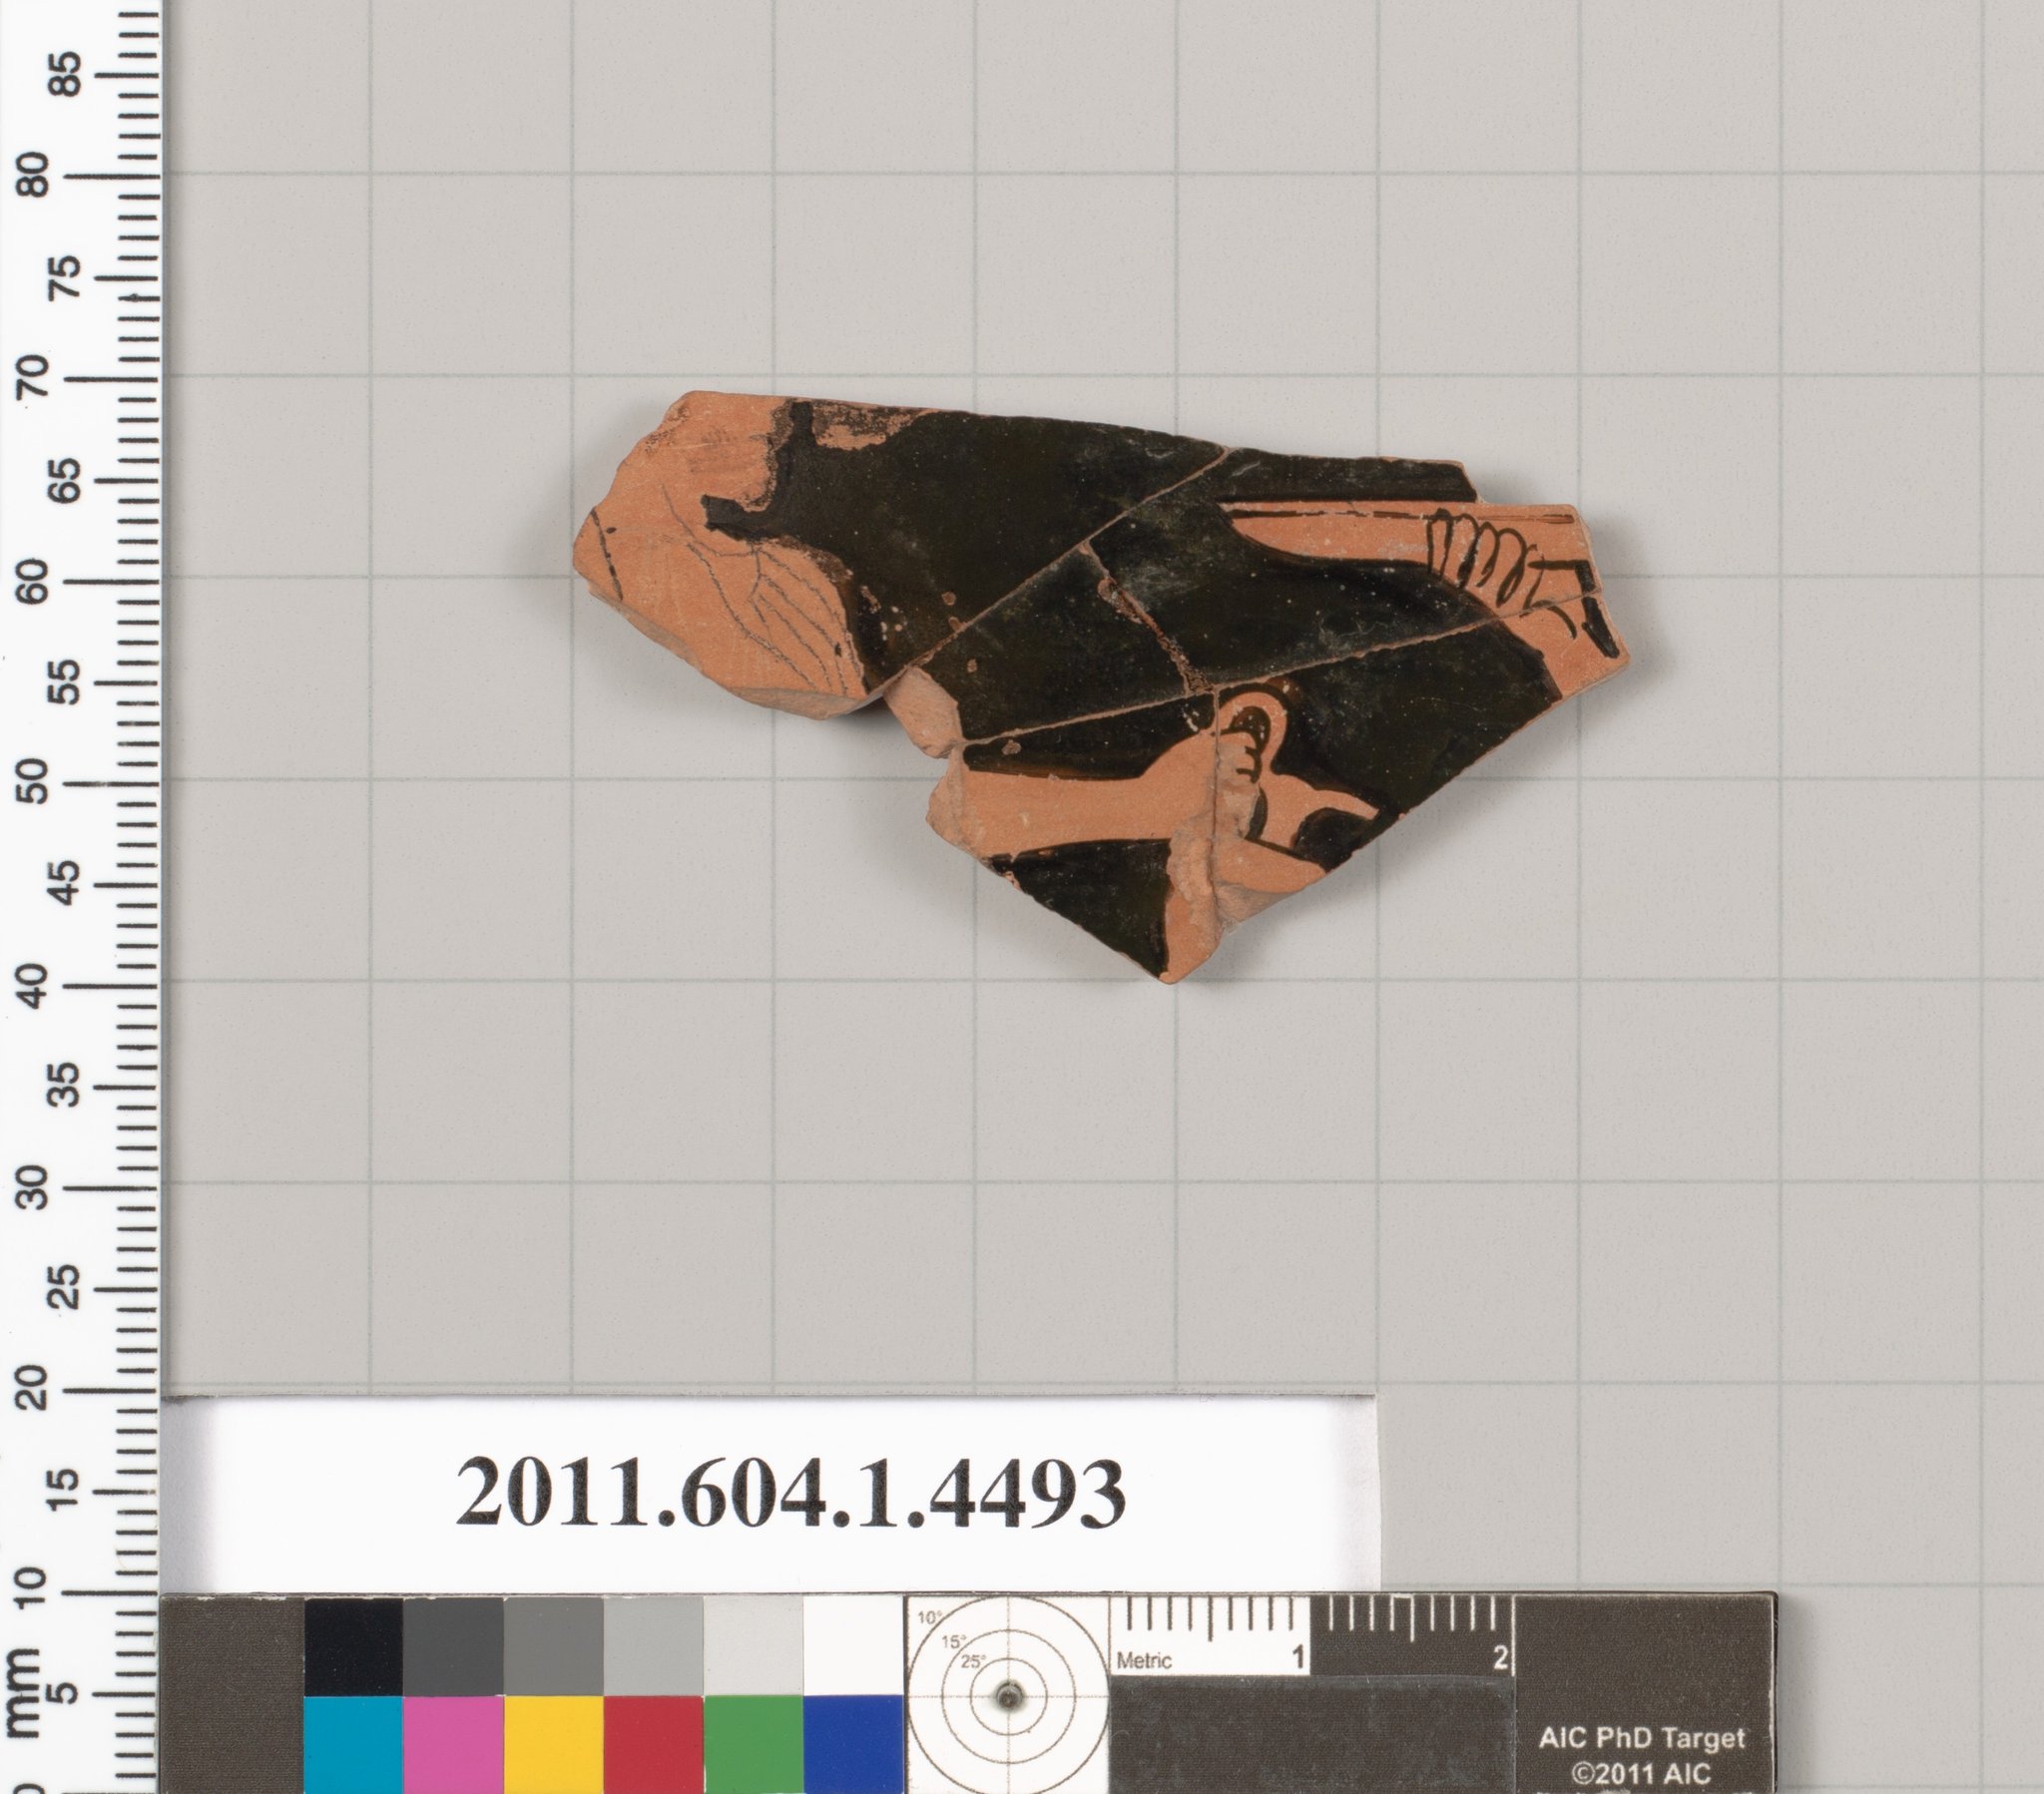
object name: kylix fragment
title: Terracotta fragment of a kylix (drinking cup)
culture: greek, attic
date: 480-470 BCE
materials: terracotta